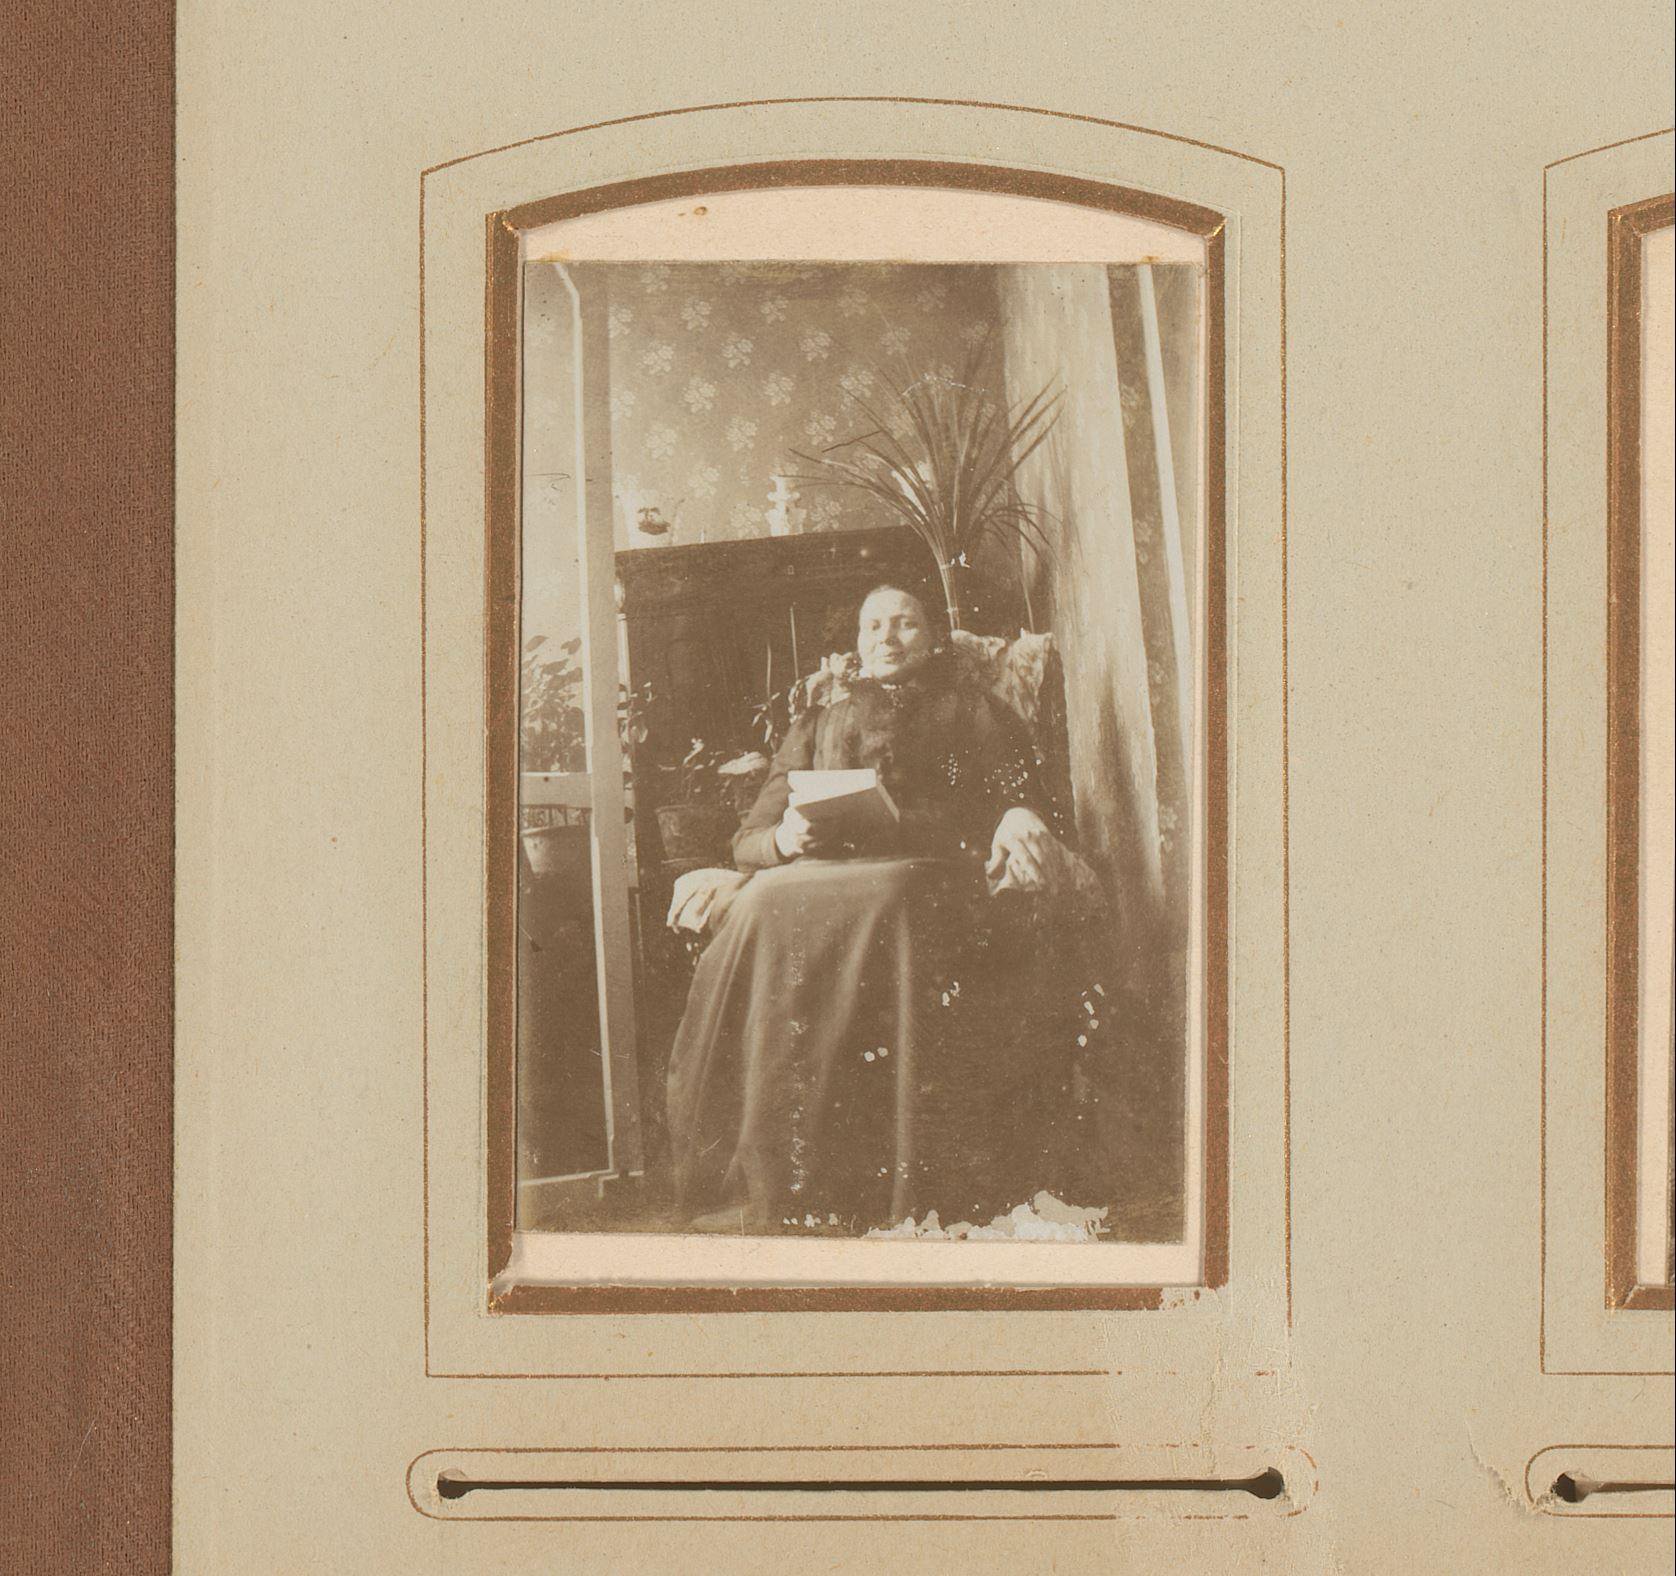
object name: photograph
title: Portret van een vrouw met boek in de hand, zittend in een interieur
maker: Anonymous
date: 1880-1920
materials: cardboard, photographic support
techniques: collodion silver print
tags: sitting figure - aa - female human figure, historical persons - bb - woman, book, interior of the house